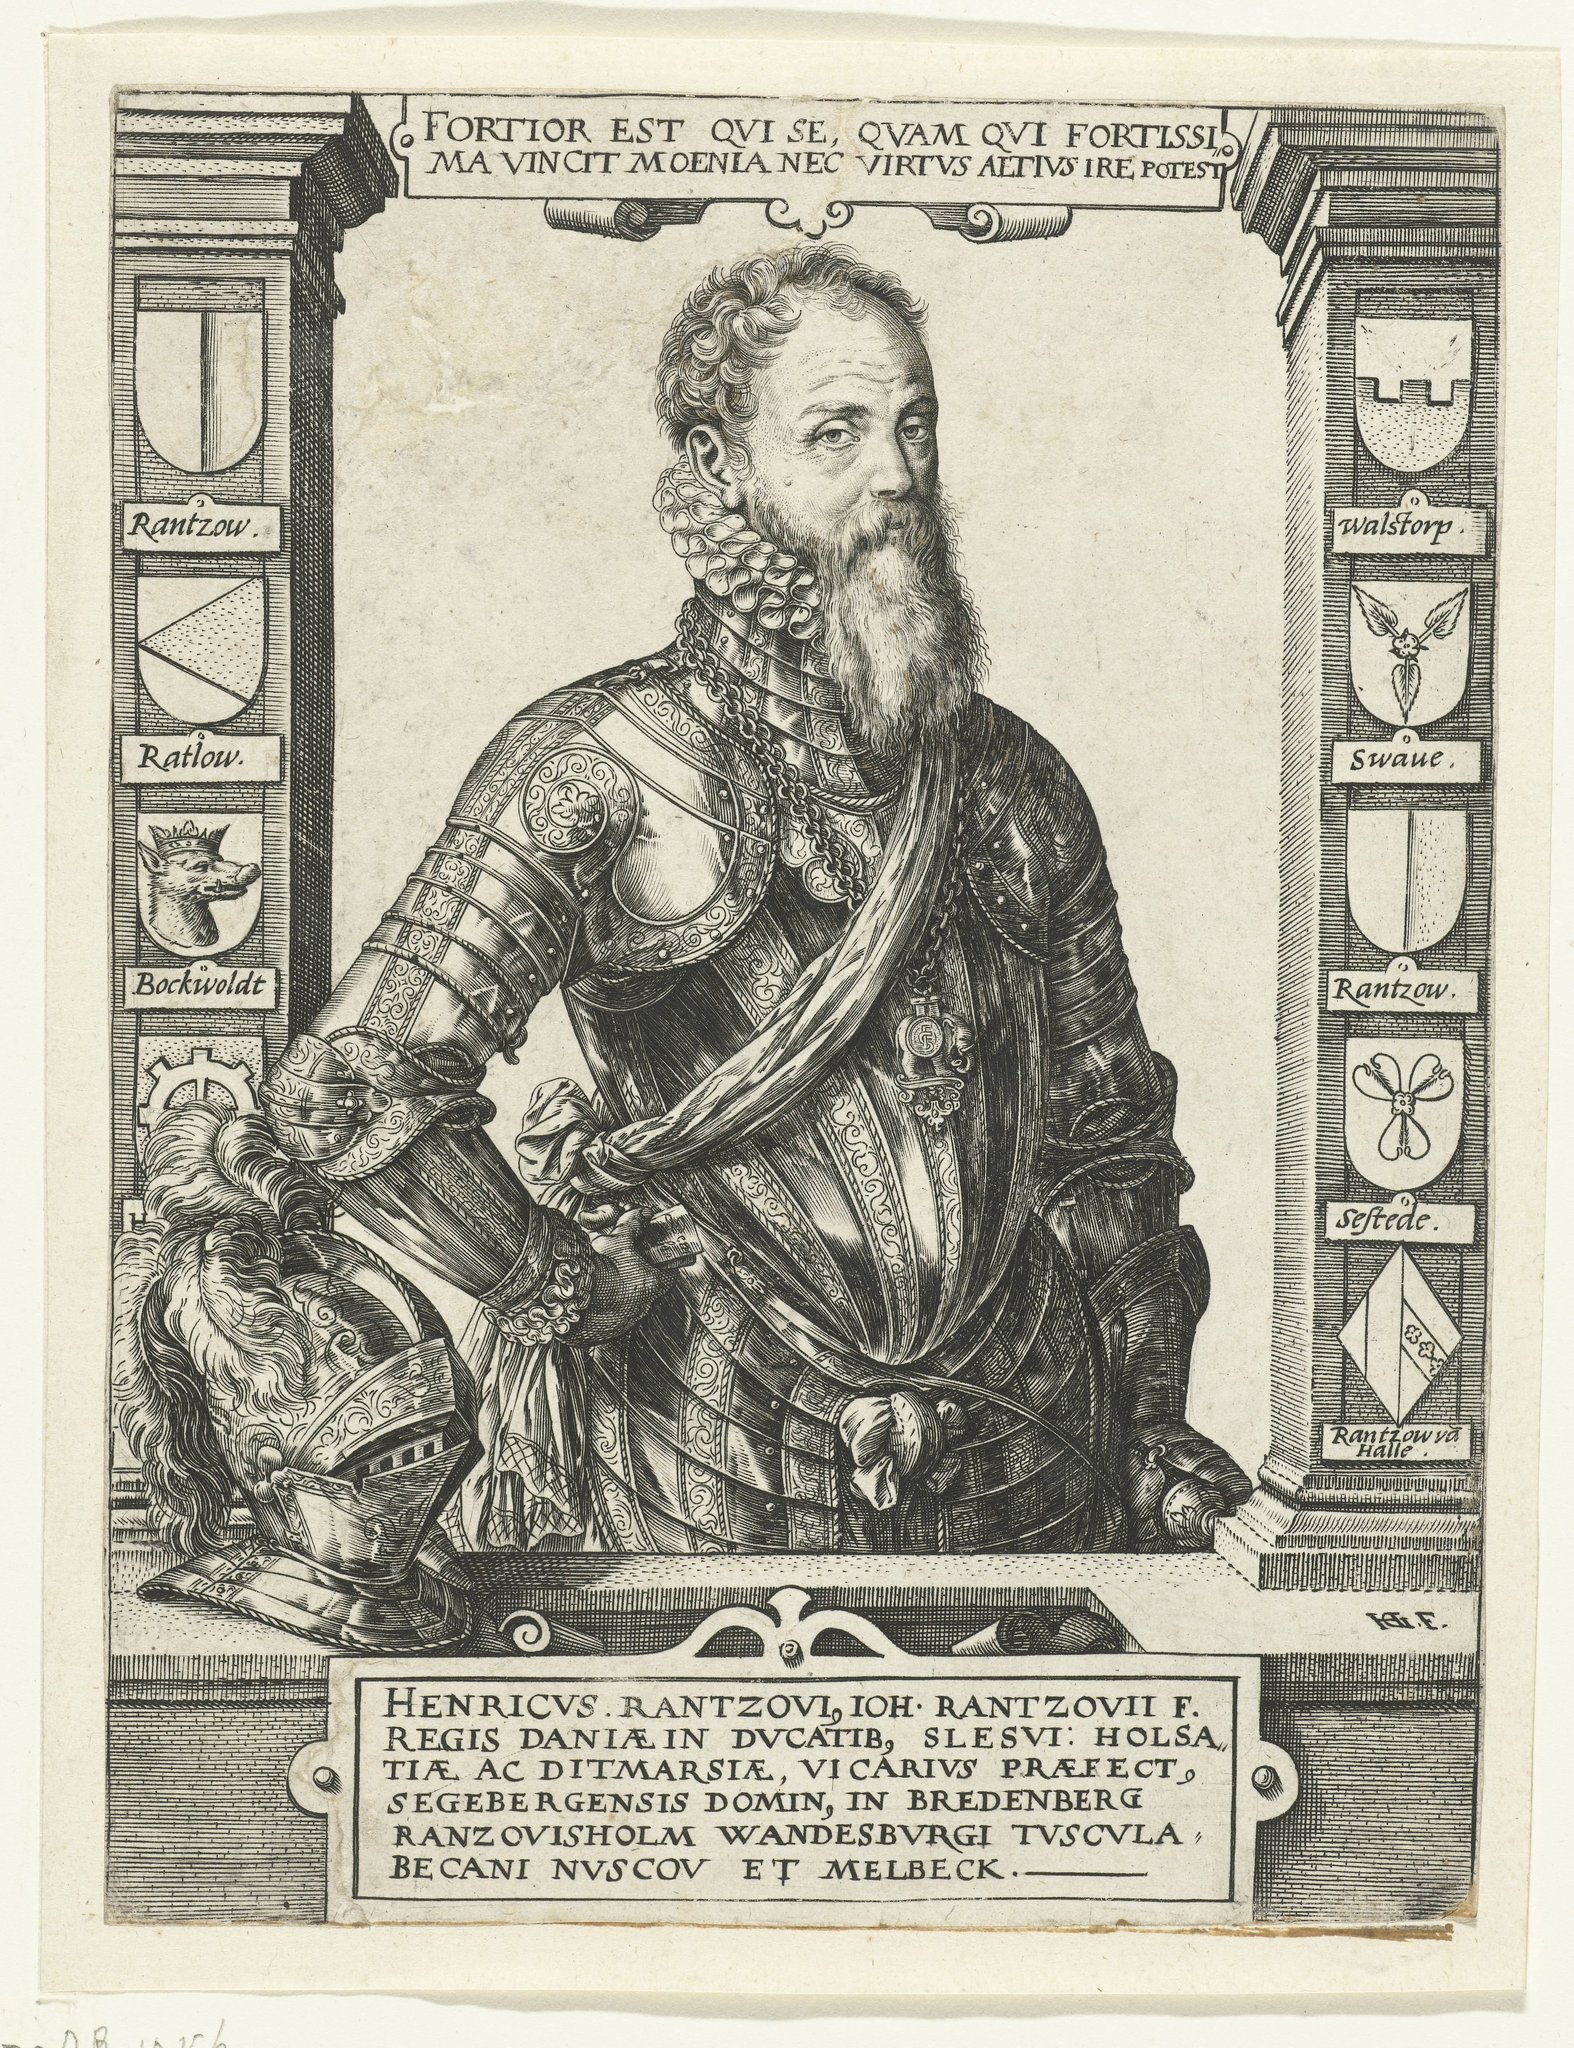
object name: print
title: Portret van Heinrich von Rantzau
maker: hendrick goltzius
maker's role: draughtsman, painter, print maker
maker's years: 1558-1617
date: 1587-1591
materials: paper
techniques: engraving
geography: haarlem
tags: historical persons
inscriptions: monogram: ‘HG F.’, collector's mark: Lugt 240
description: Portret van de Deense gouverneur van de provincie Holstein, Heinrich von Rantzau (1525-1598). Ten halven lijve weergegeven, staand aan een raamkozijn, waarvan de zuilen aan weerszijden versierd zijn met wapenschilden. De gouverneur draagt een harnas. Zijn helm ligt links op de balustrade. Boven en onder het portret inscripties in Latijn in een kader.